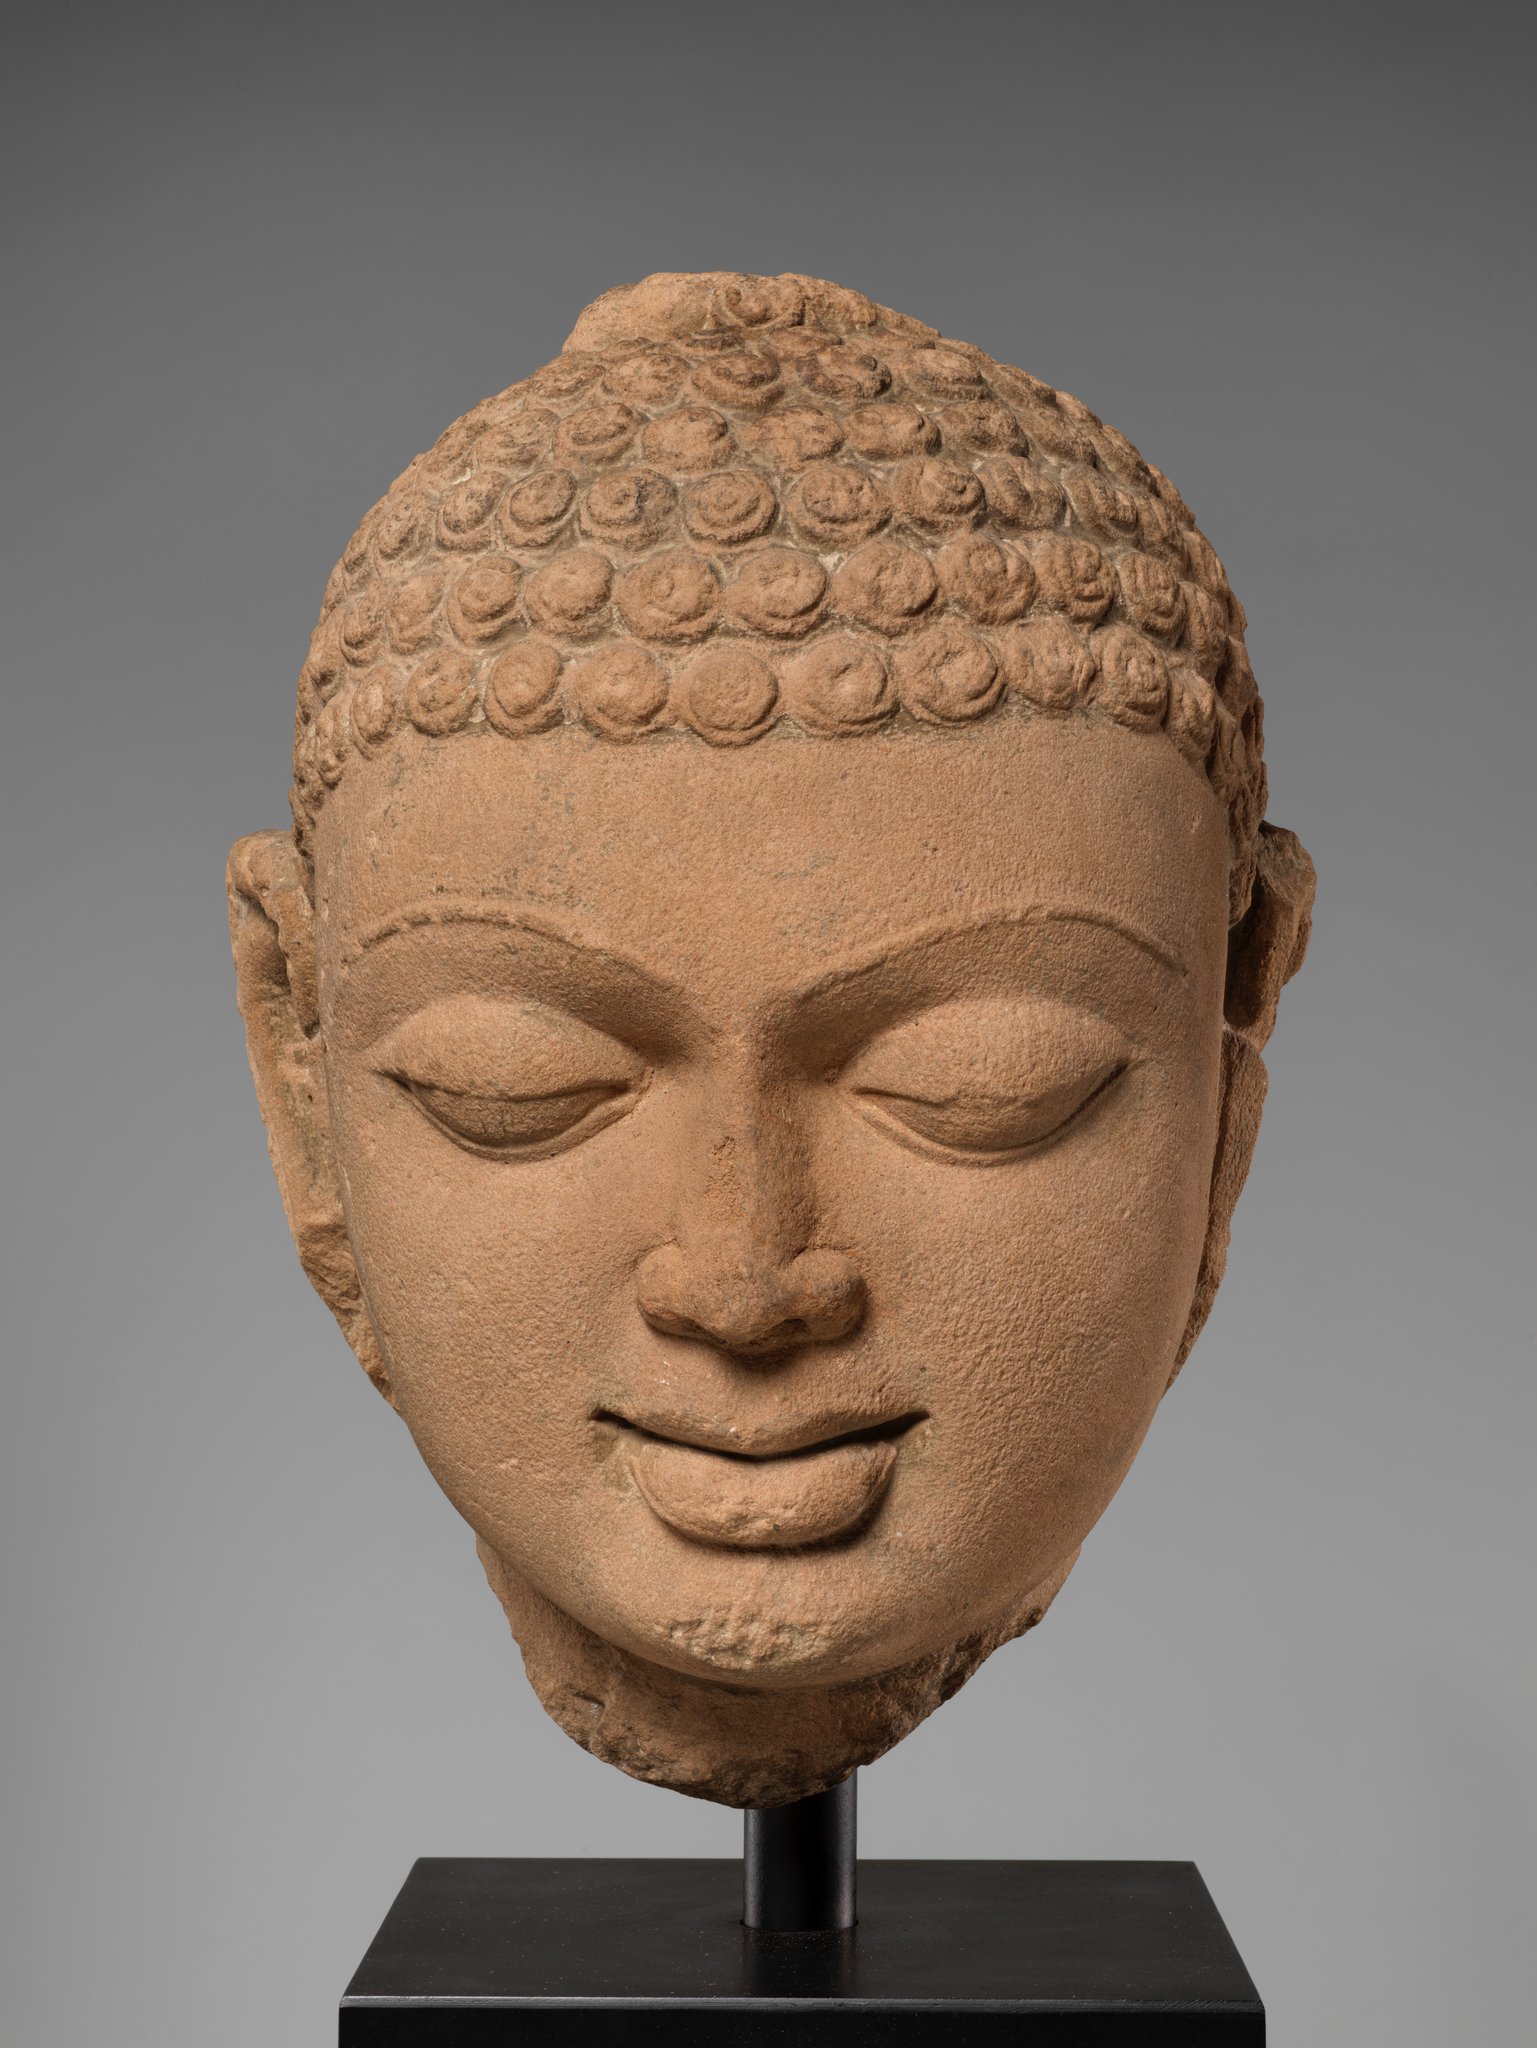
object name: figure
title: Head of a Buddha (Study Collection)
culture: indian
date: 1901-2000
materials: stone